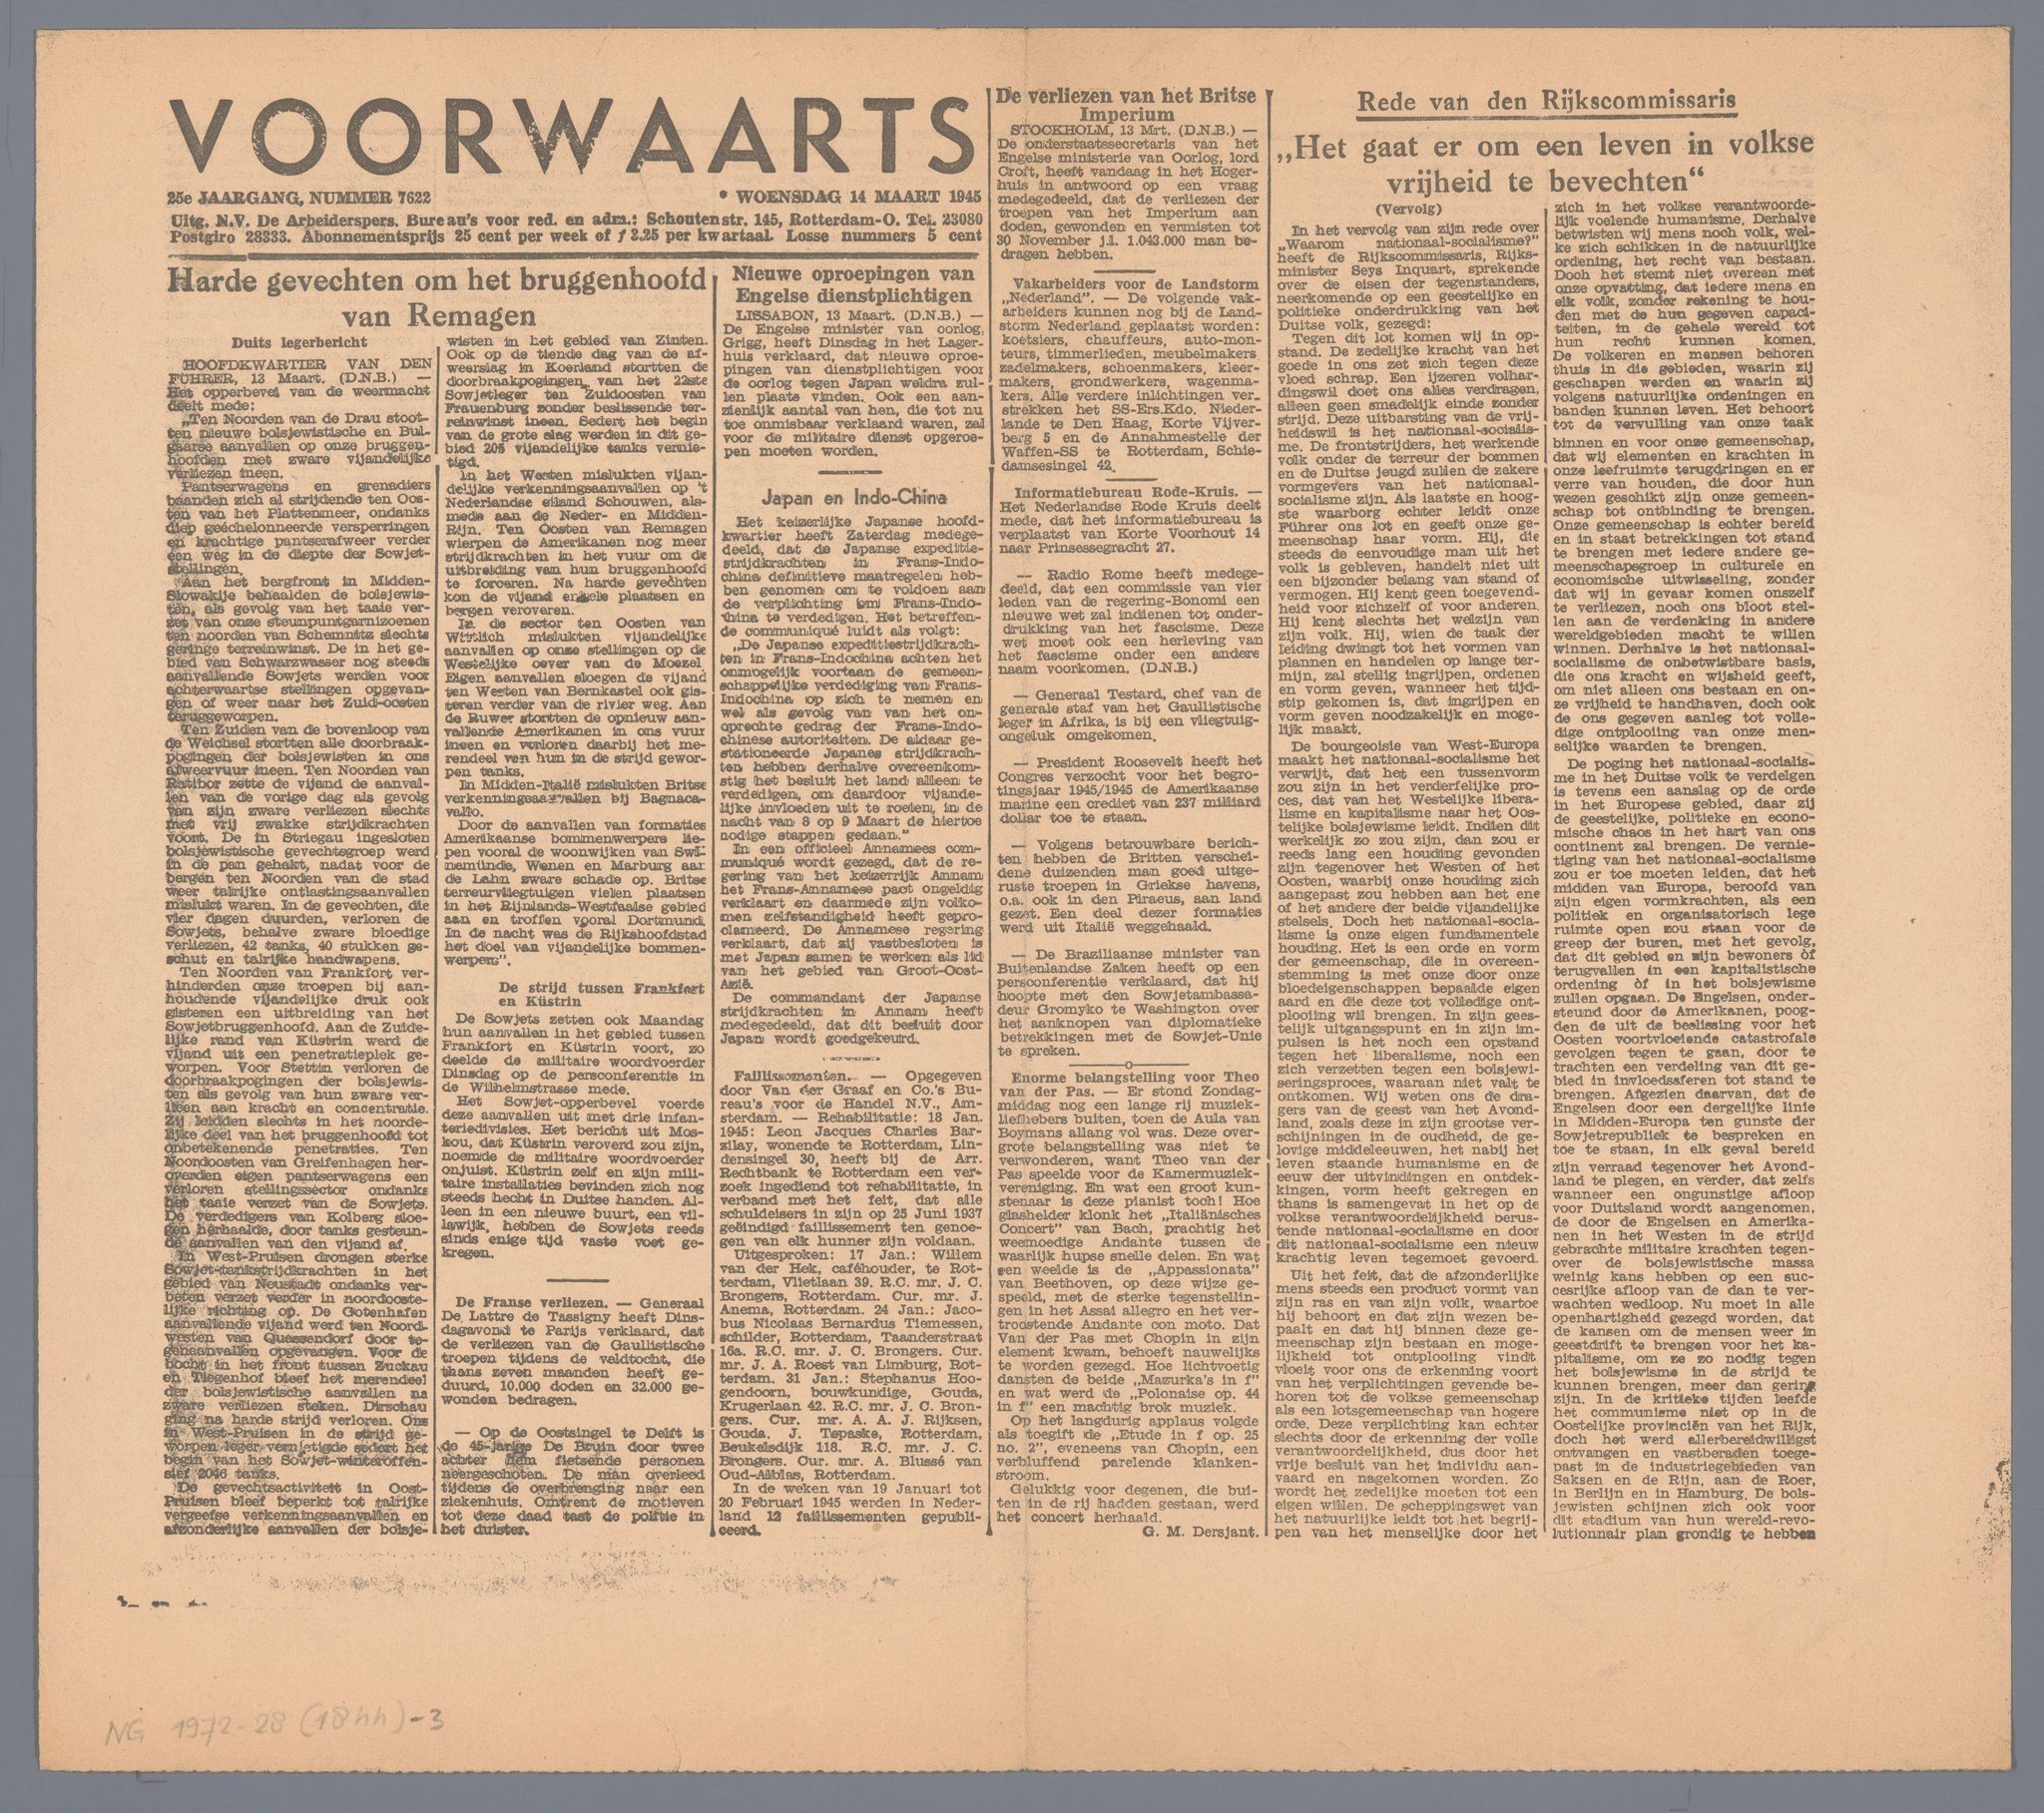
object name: newspaper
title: Voorwaarts, 14 maart 1945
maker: h.m.c. schröder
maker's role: redacteur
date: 1945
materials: paper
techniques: printing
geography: europe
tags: europe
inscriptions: date: ‘14 maart 1945’, inscription: ‘Harde gevechten om het bruggehoofd in Remagen’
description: Nummer 7622, 25ste jaargang van Voorwaarts, 1 blad (2 pp). Opschrift; voorp.: 'Harde gevechten om het bruggehoofd in Remagen'. Woensdag 14 maart 1945